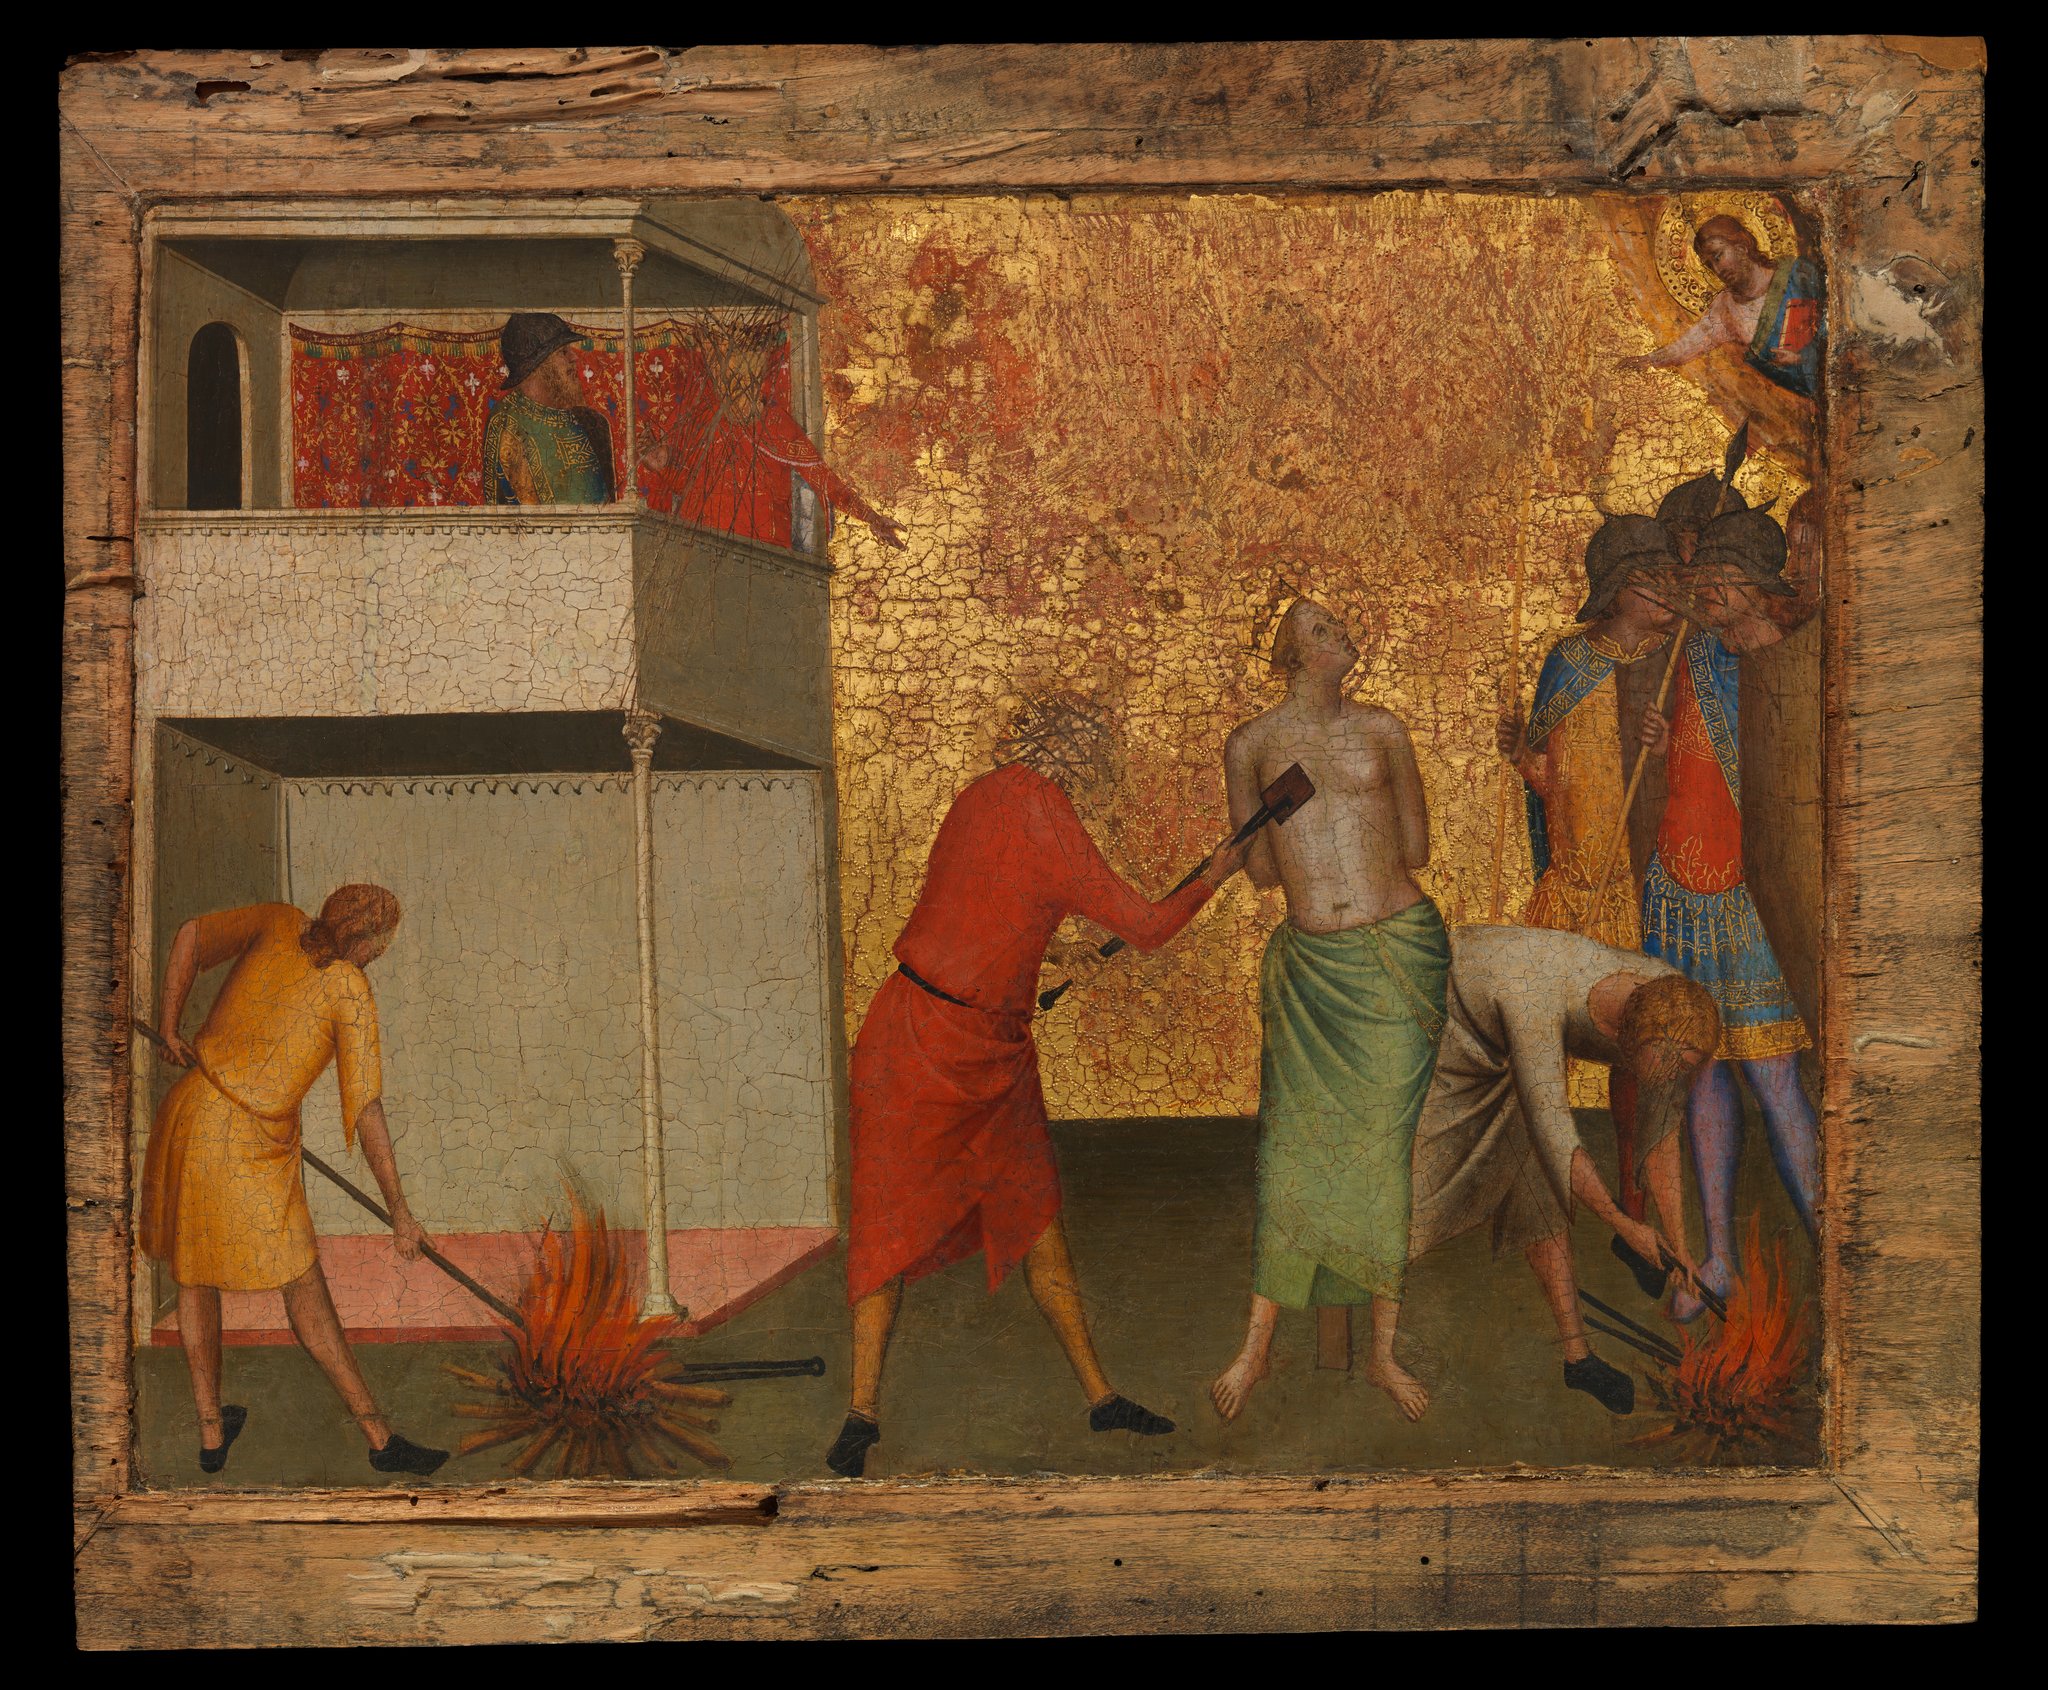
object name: painting, predella panel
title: Saint Reparata Tortured with Red-Hot Irons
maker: bernardo daddi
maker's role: artist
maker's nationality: italian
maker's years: 1290-1348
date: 1327-1348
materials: gold leaf, paint, wood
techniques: tooling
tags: suffering,women,saints